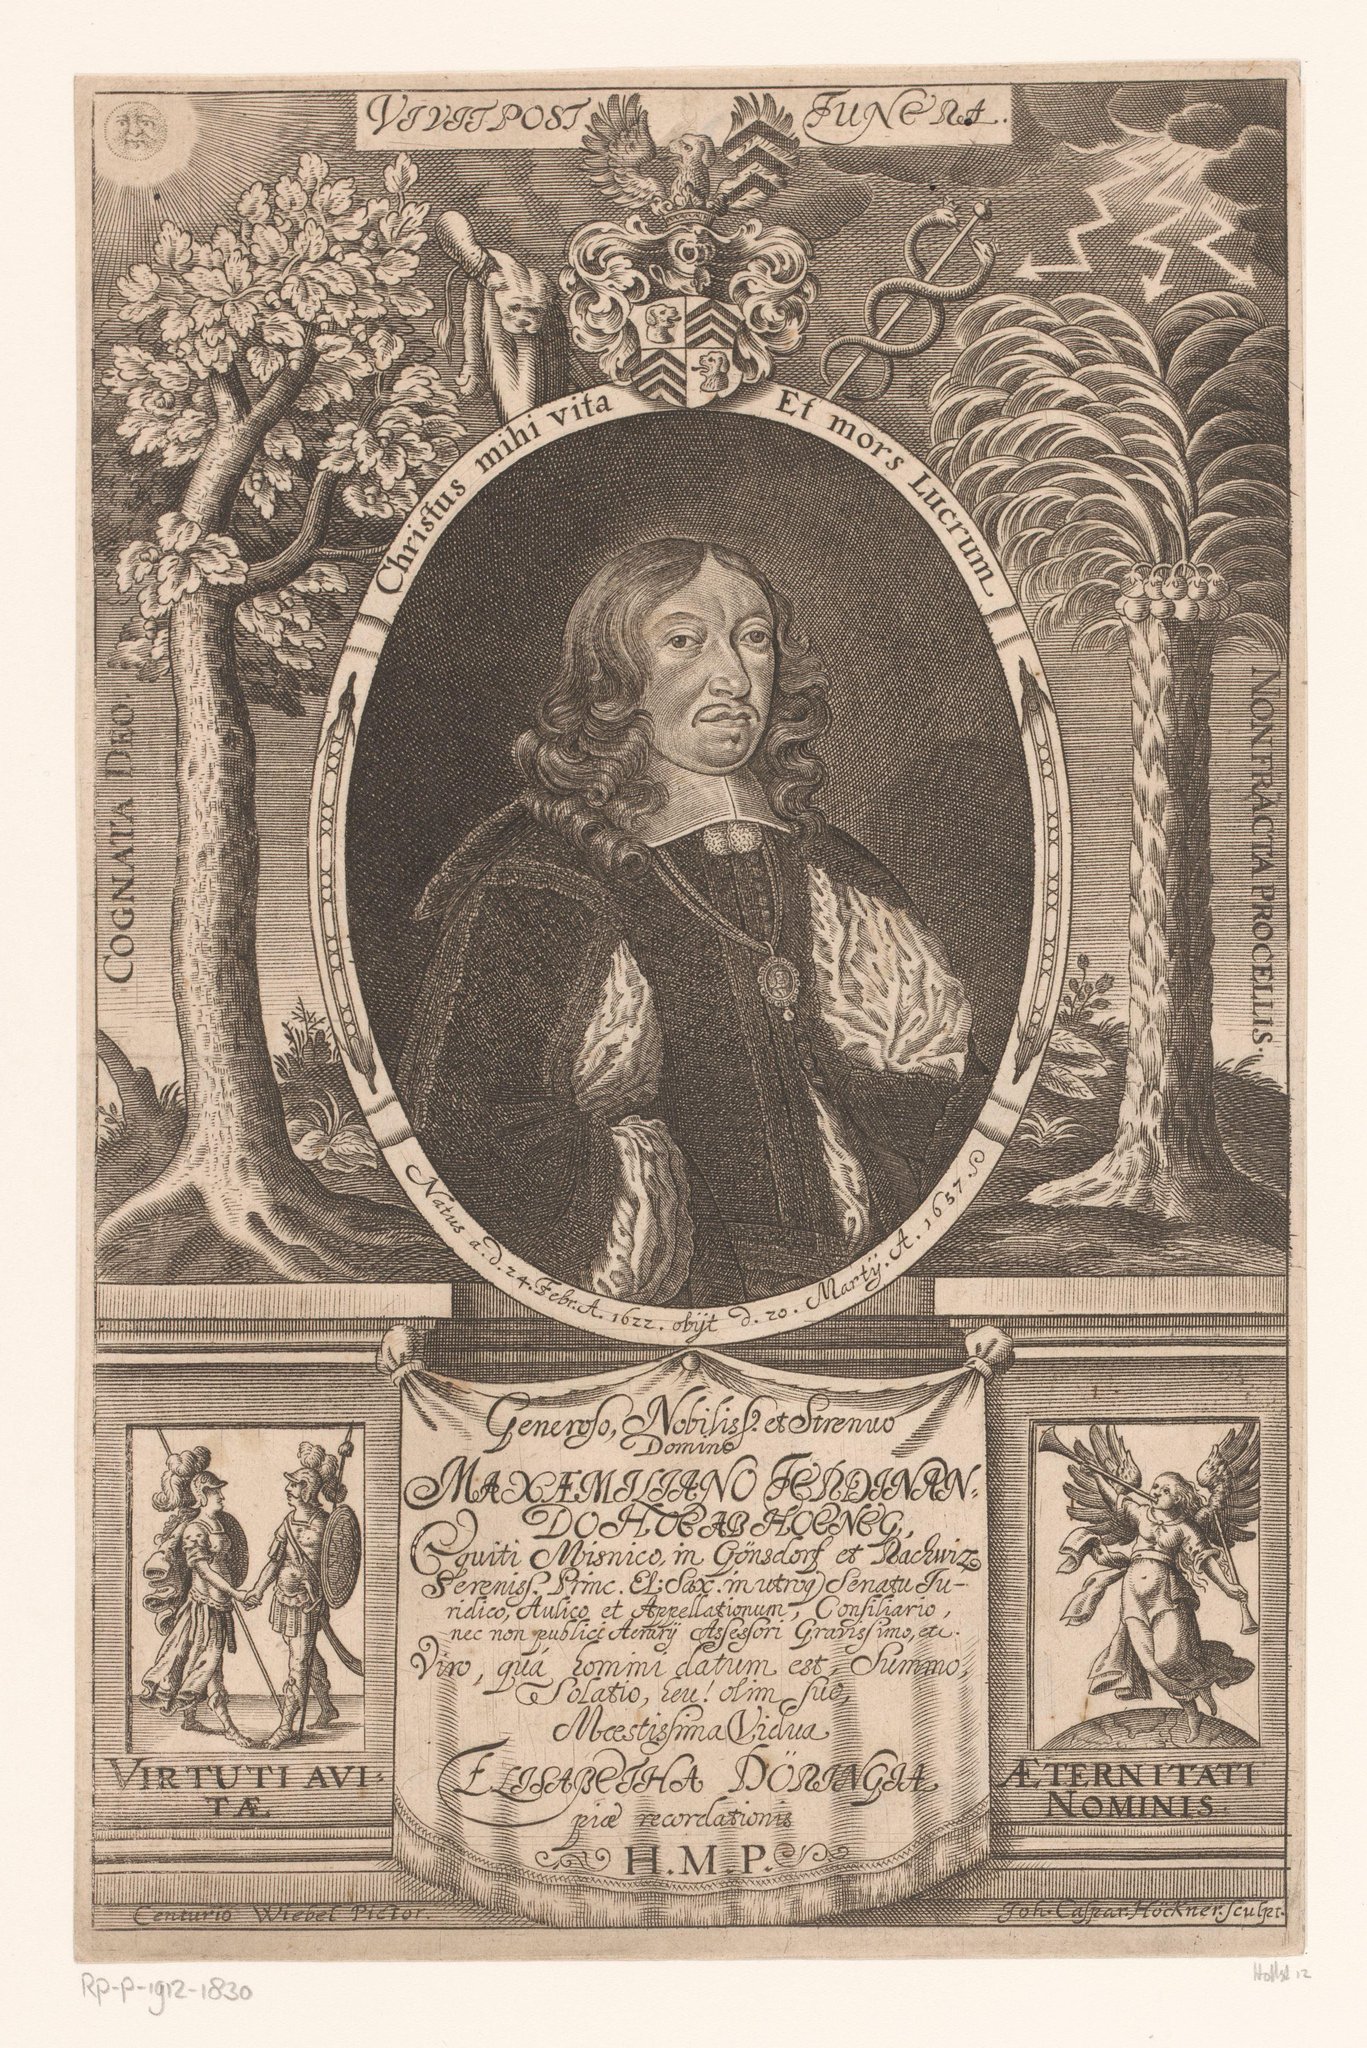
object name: print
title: Portret van Maximilian Ferdinand Hoë von Hoënegg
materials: paper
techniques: engraving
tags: thunder, attributes of hercules, historical persons, trees: oak, pendant, trinket, 'breloque', sun represented as face, wheel, etc., trees: palm-tree, attributes of mercury, abstract ideas and concepts (+ emblematical representation of concept), armorial bearing, heraldry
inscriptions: collector's mark: Lugt 2228